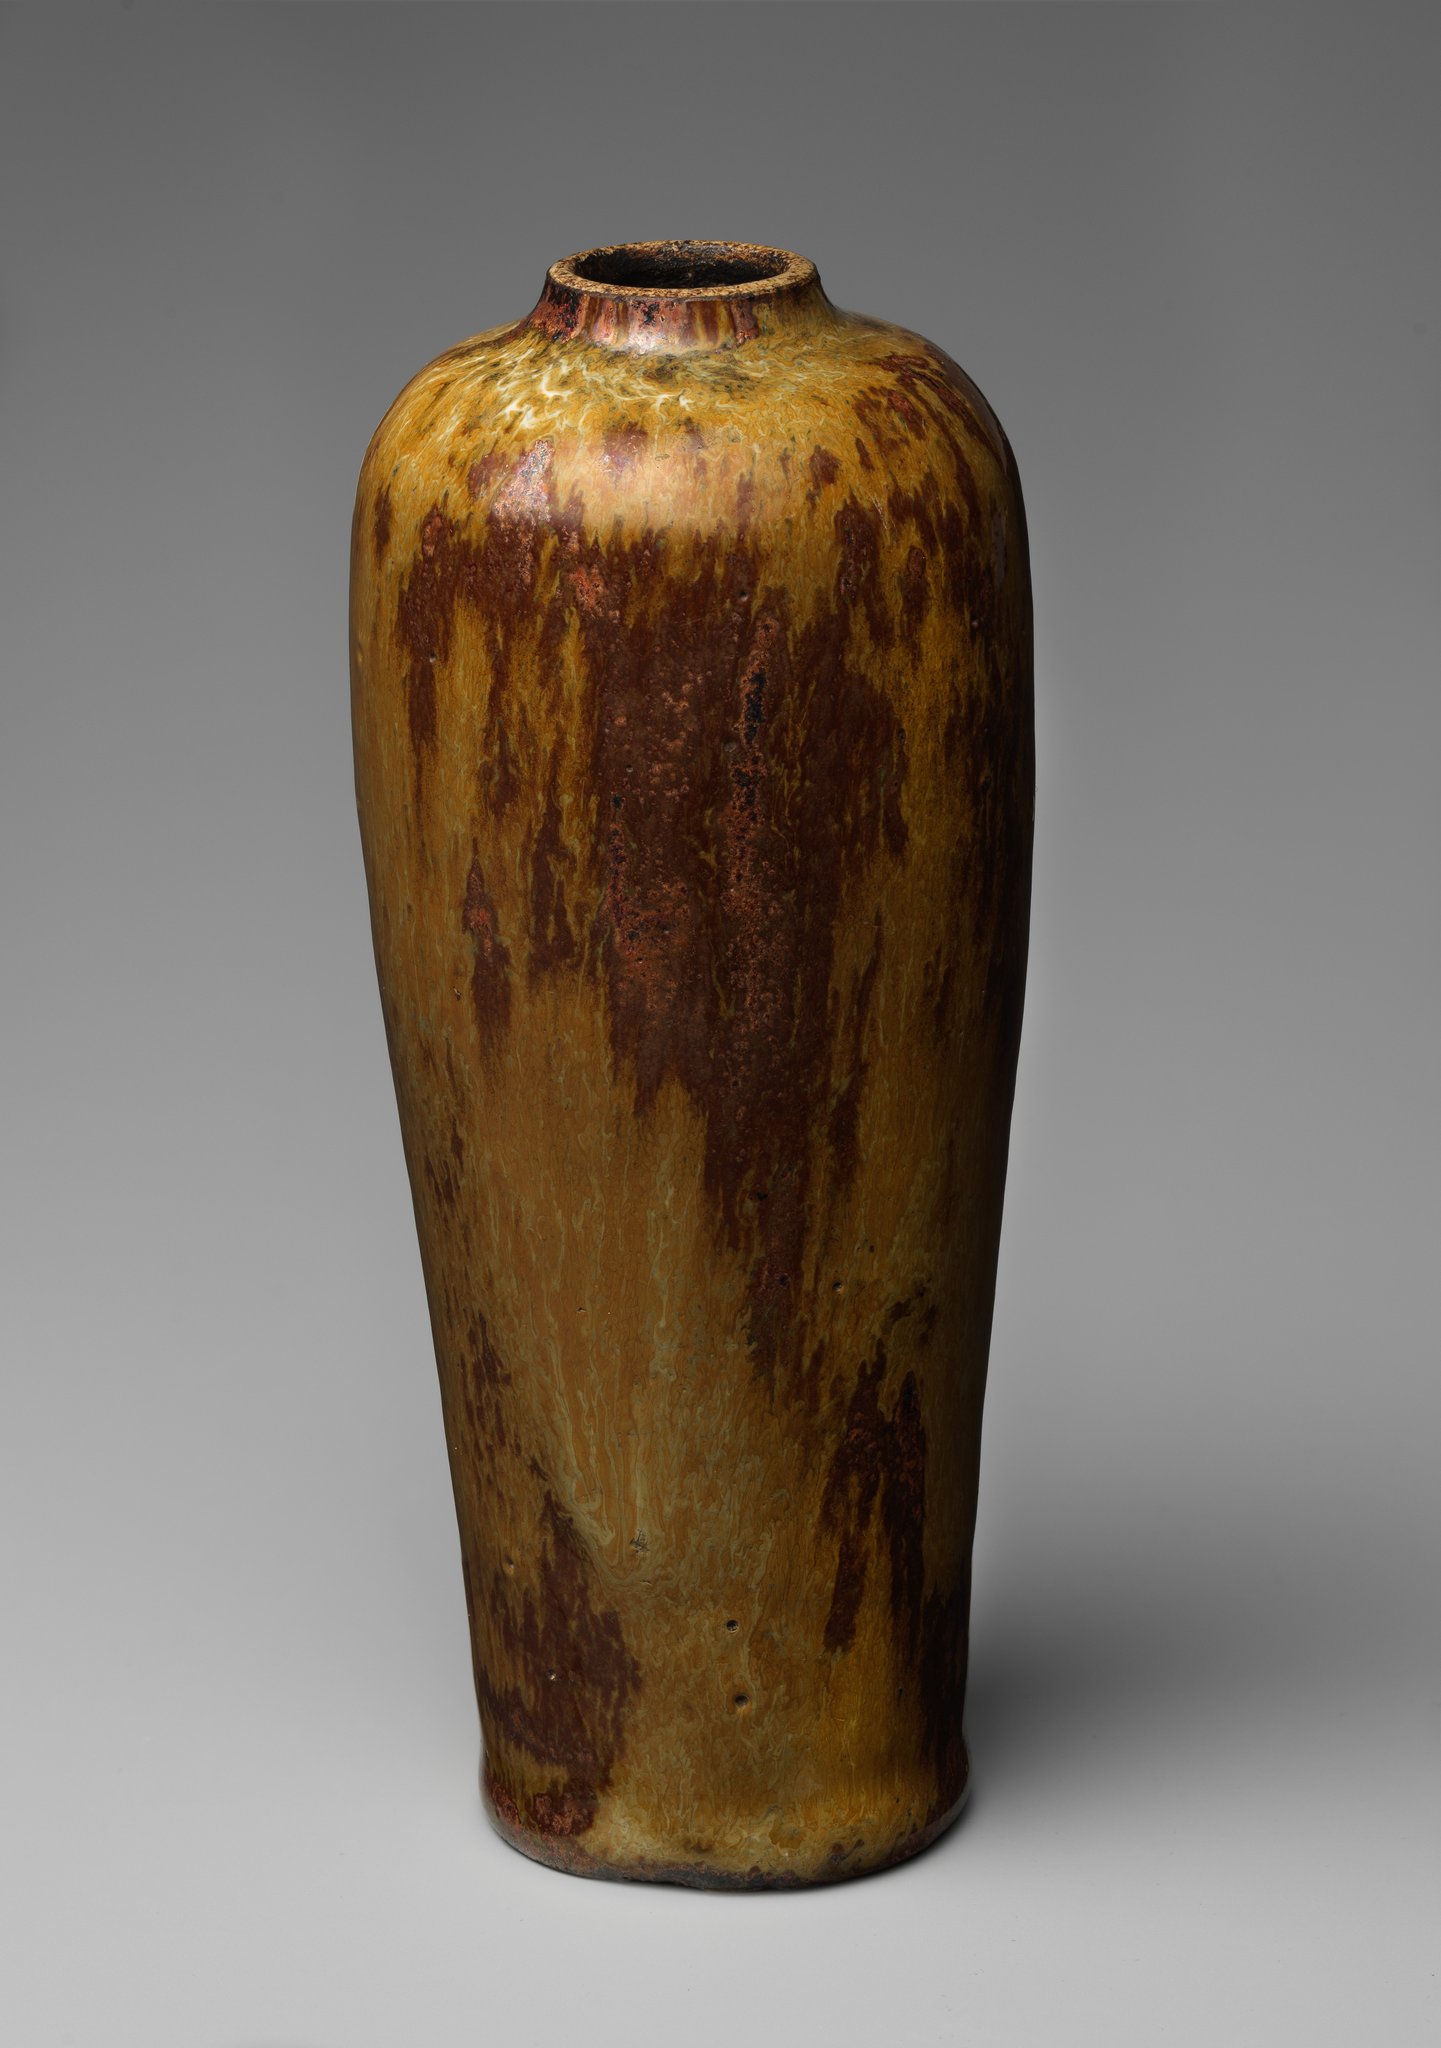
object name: vase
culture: japanese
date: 1701-1900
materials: glaze, pottery